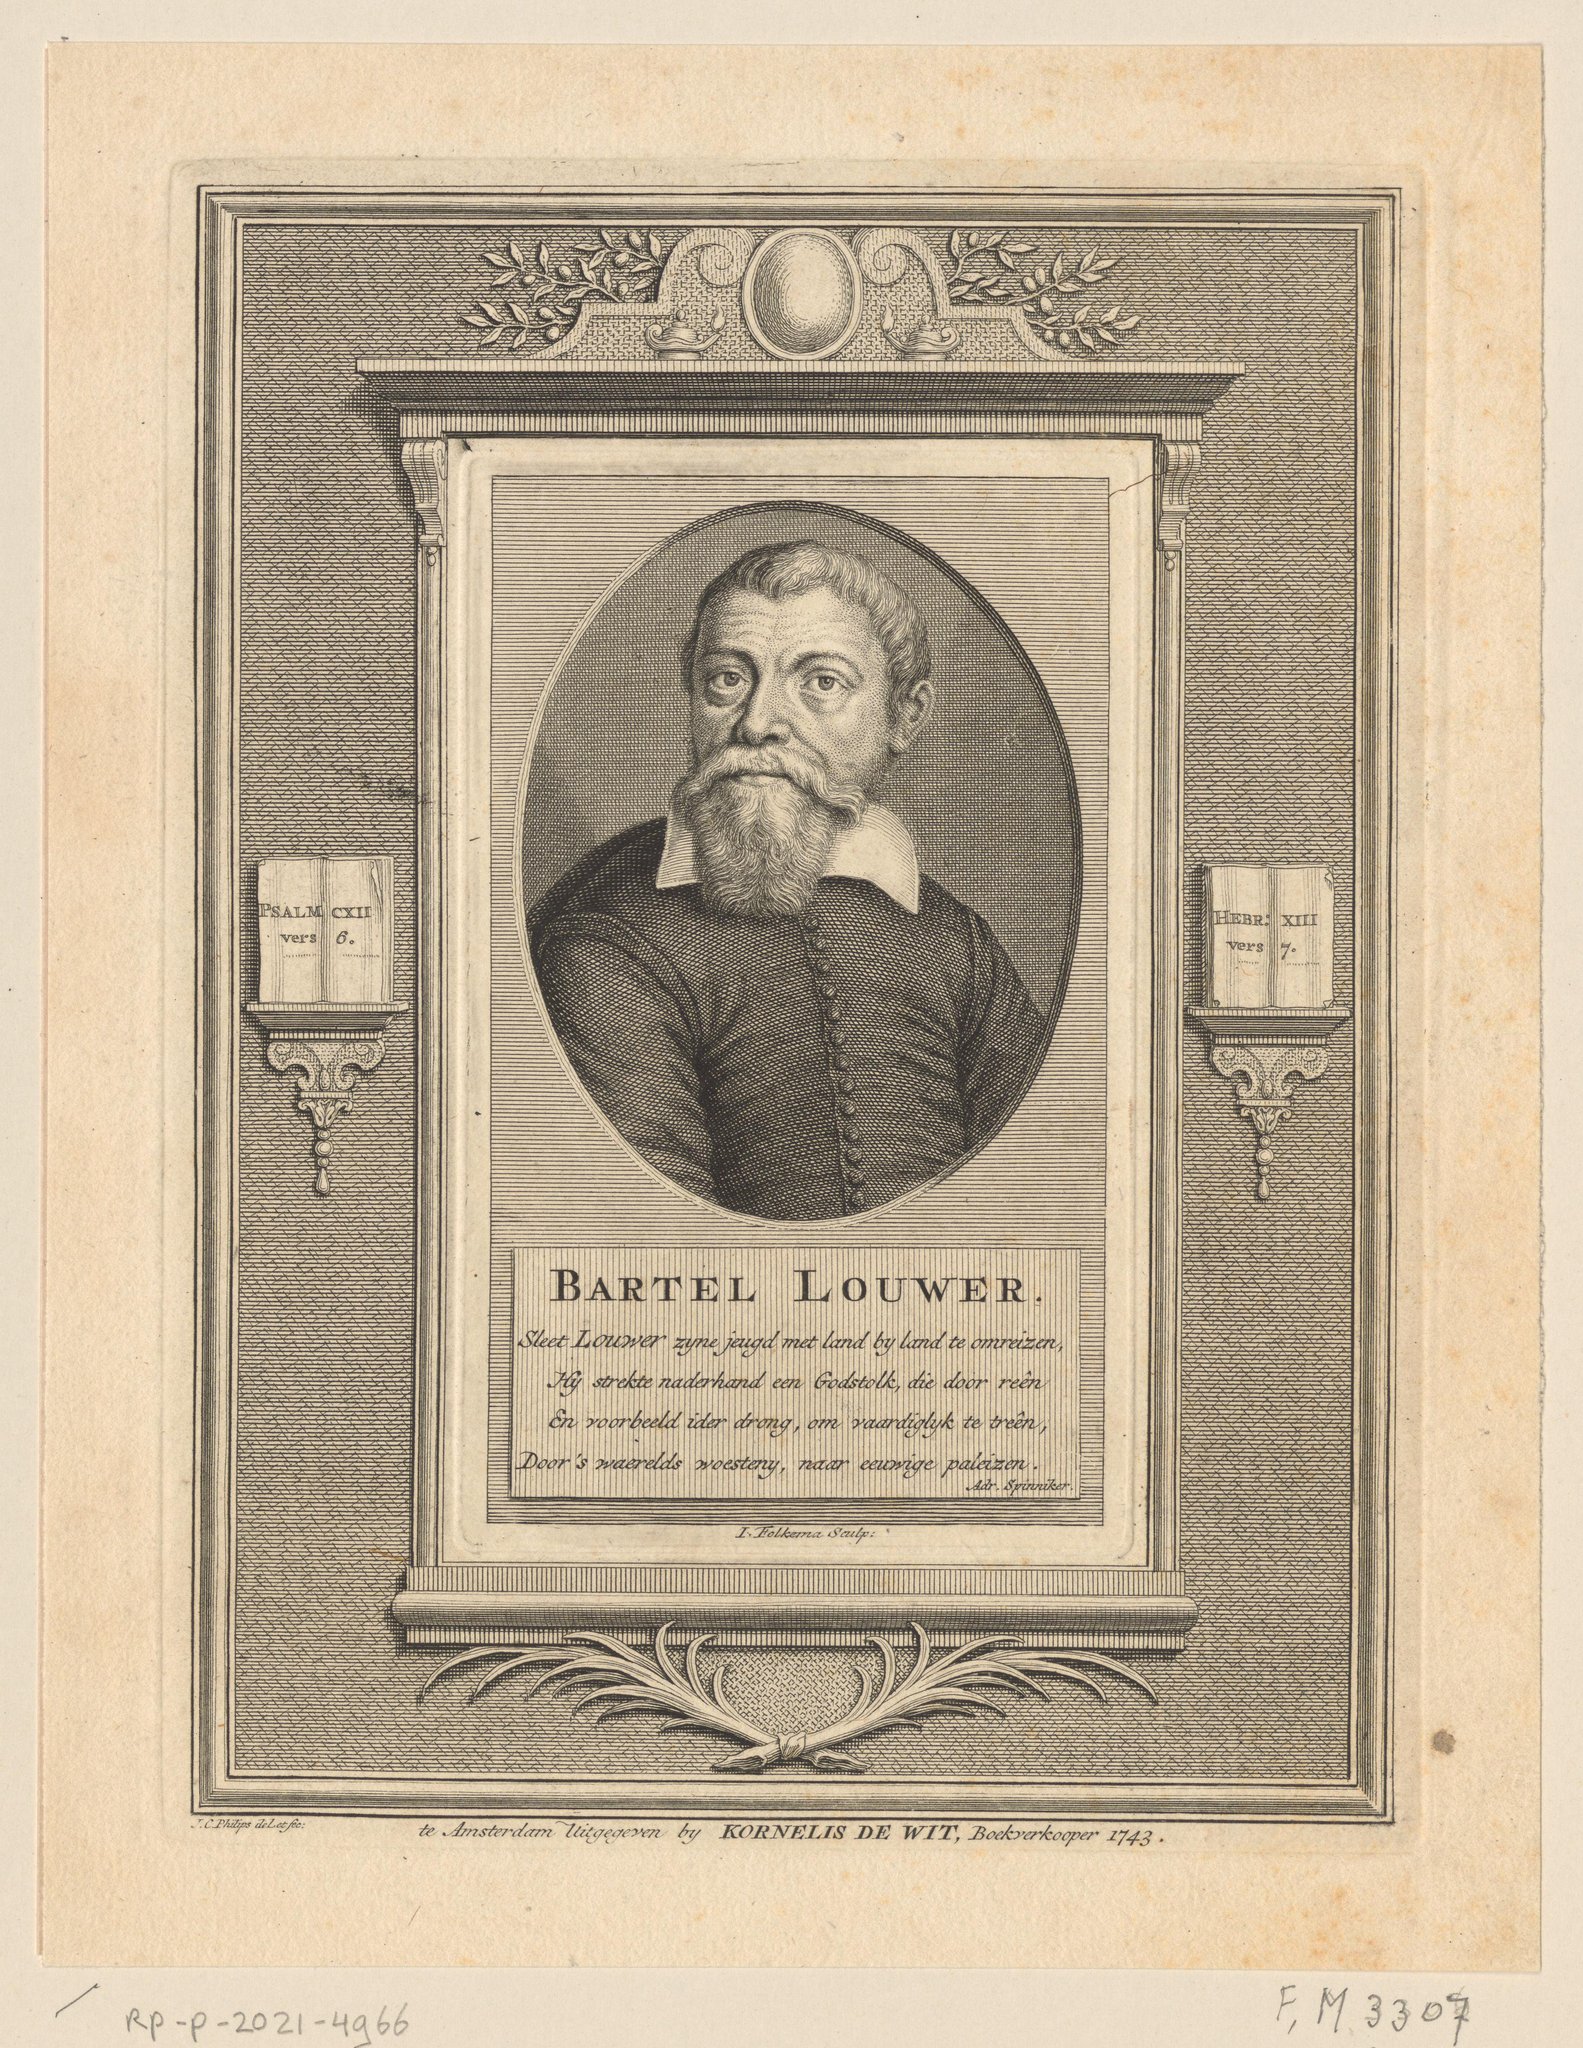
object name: print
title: Portret van Bartel Louwer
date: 1743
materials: paper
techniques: engraving, etching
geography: amsterdam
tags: historical persons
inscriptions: date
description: Zonder omlijsting is de prent gebruikt in: Schijn, Hermannus. Geschiedenis dier christenen, welke in de Vereenigde Nederlanden onder de protestanten mennoniten genaamd worden. Amsterdam: Kornelis de Wit, 1743.